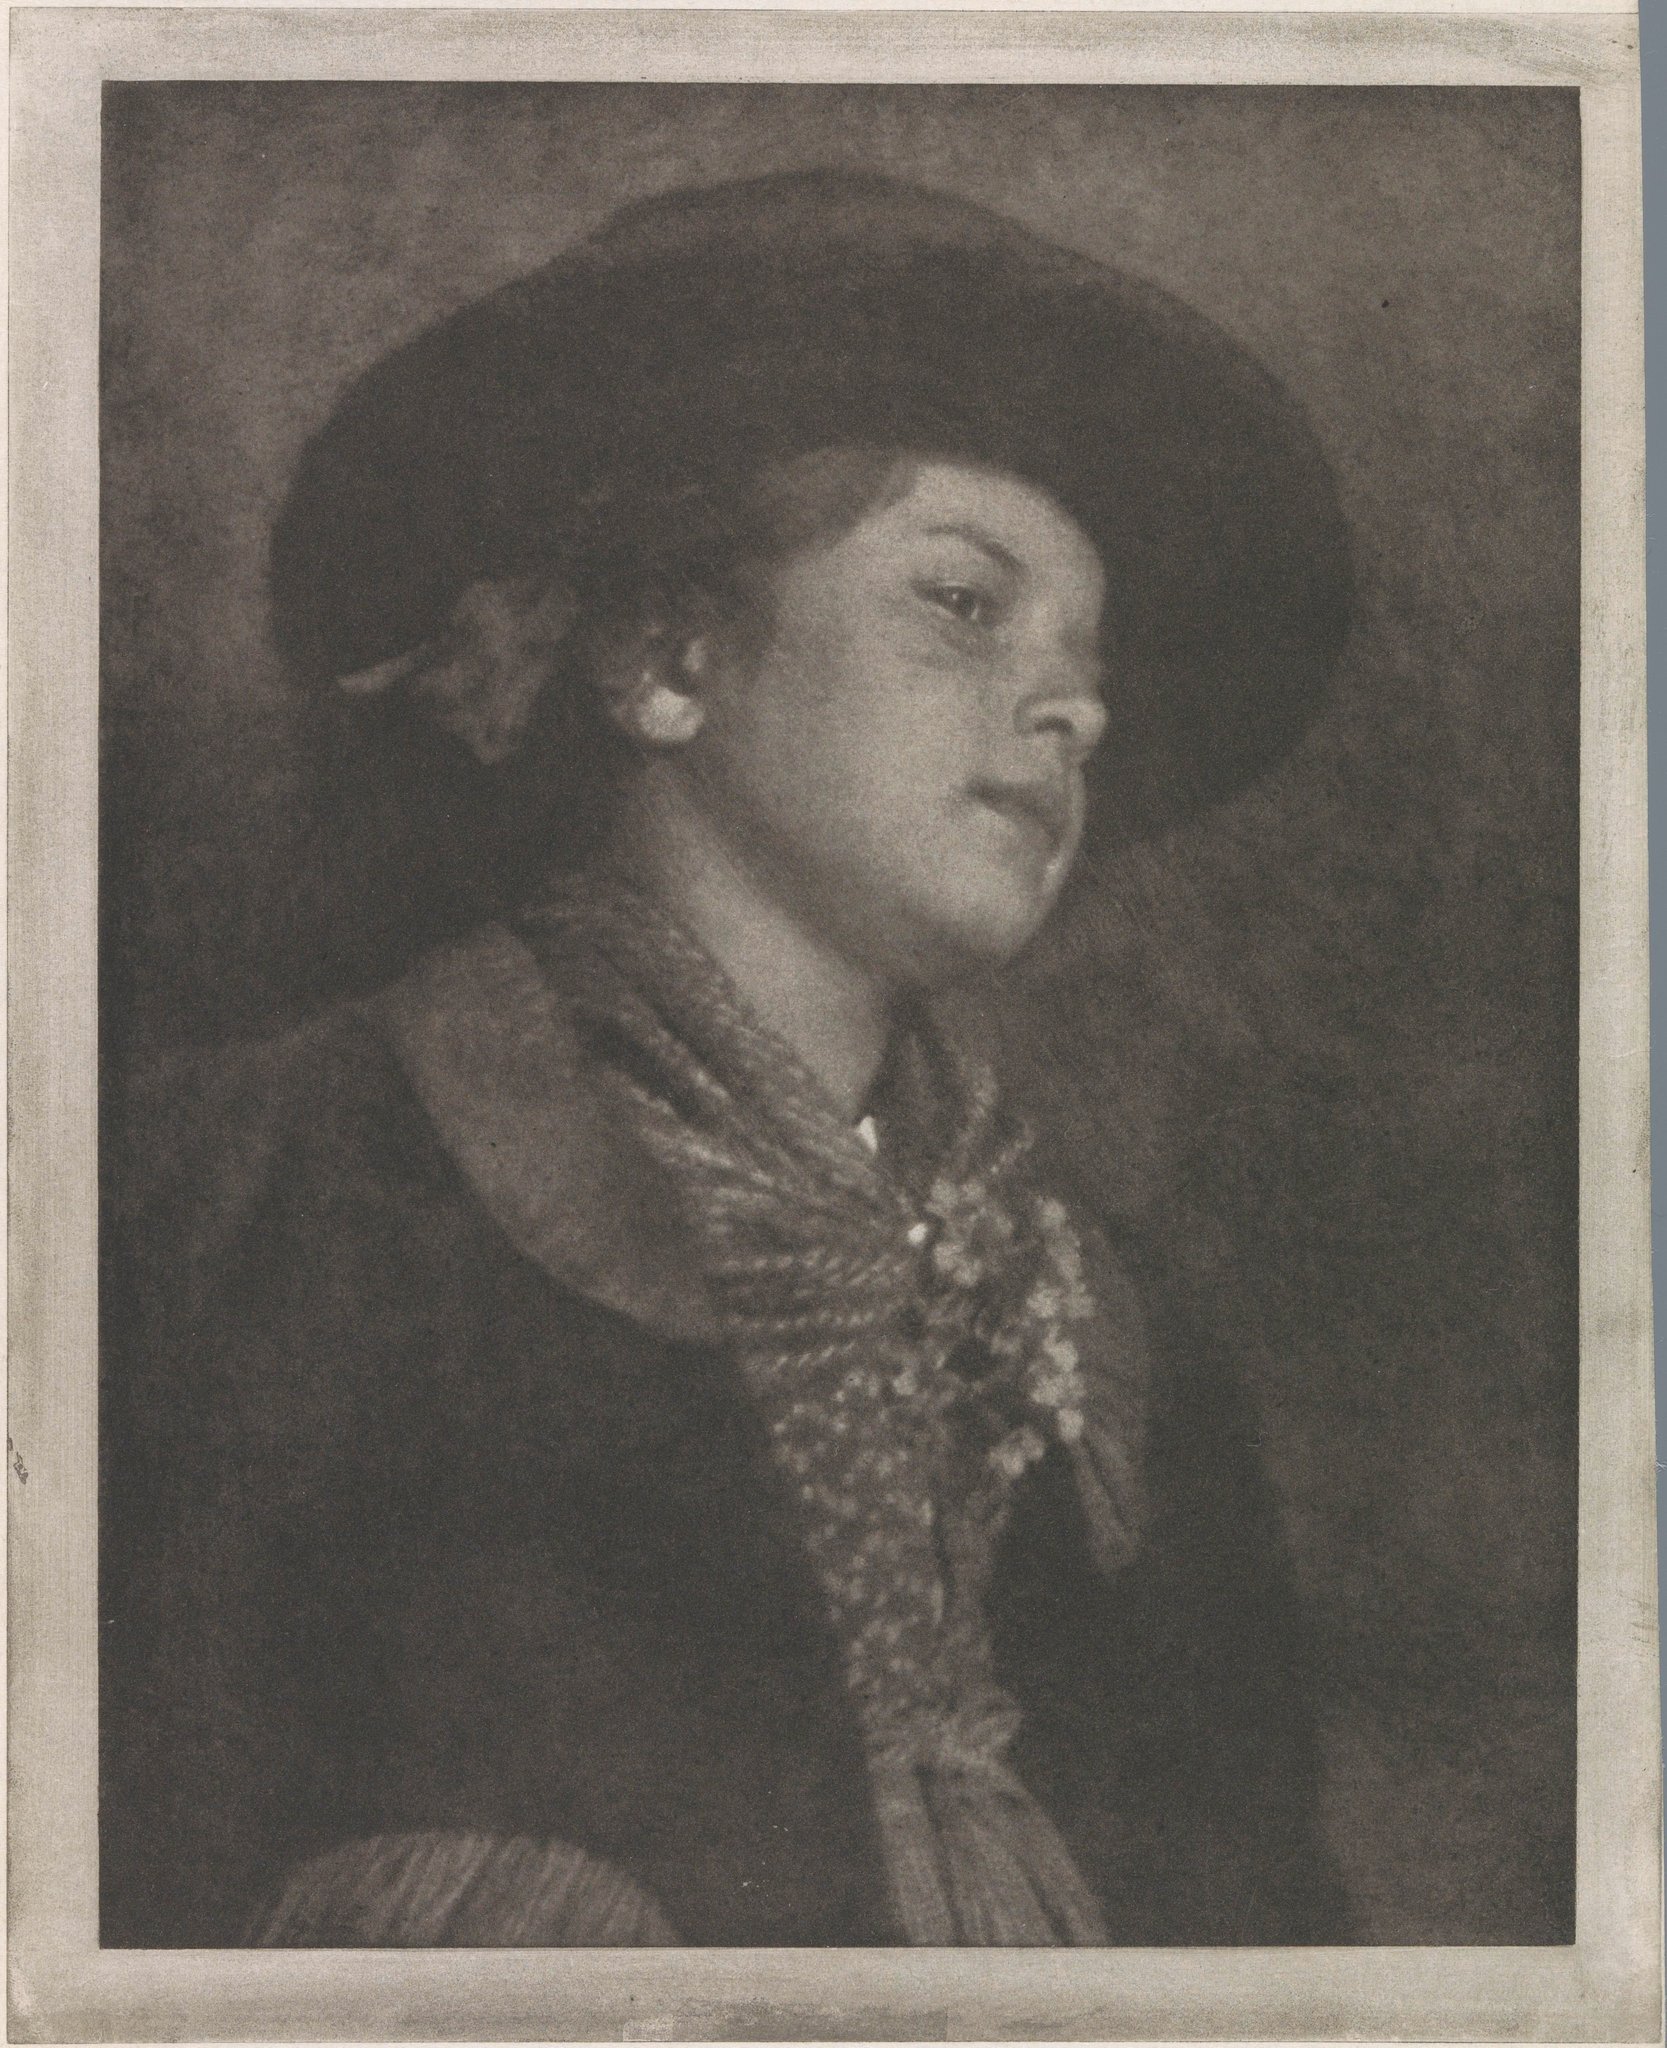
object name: photomechanical print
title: Portret van Lotte Kühn, de dochter van de fotograaf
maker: heinrich kühn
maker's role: fotograaf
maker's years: 1866-1944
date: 1911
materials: paper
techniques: photoaquatint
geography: austria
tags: historical persons - bb - woman, child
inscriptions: inscription: ‘DK 23,5/ 300,39’, inscription: ‘DM 45,-’